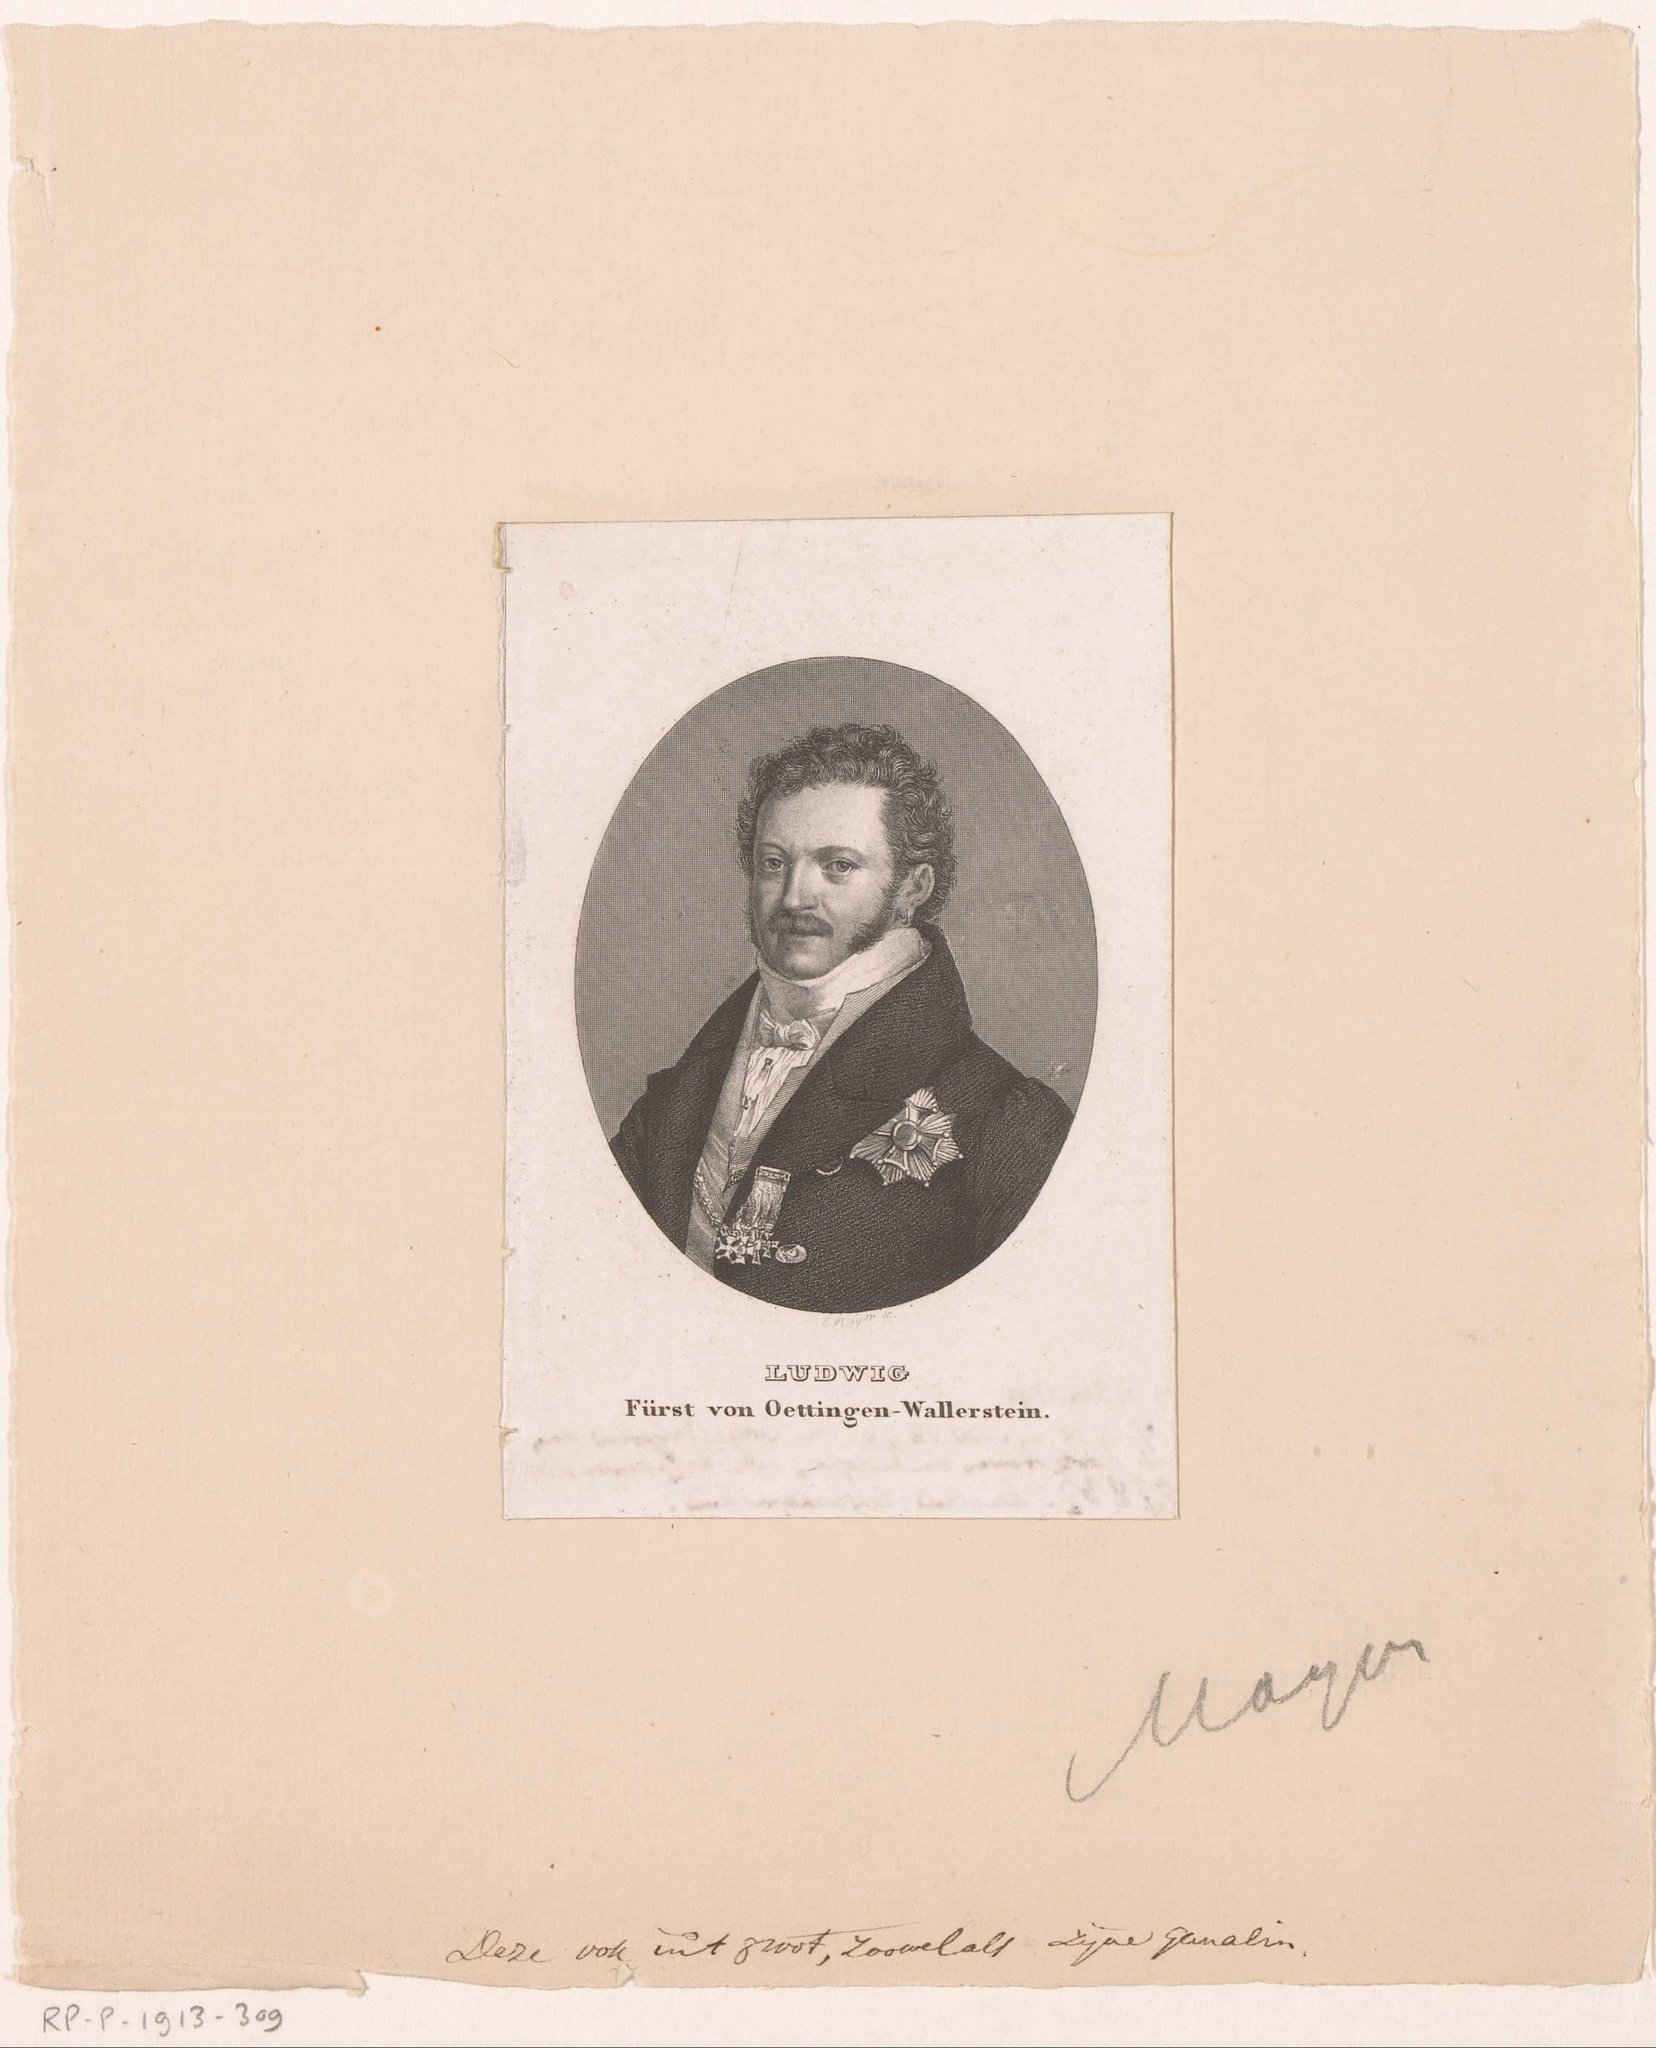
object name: print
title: Portret van Ludwig, Fürst von Oettingen-Wallerstein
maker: carl mayer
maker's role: print maker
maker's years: 1798-1868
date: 1808-1868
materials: paper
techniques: engraving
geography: nuremberg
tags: knighthood order, historical persons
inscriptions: collector's mark: Lugt 2228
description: Prent mogelijk afkomstig uit de Almanach de Gotha.